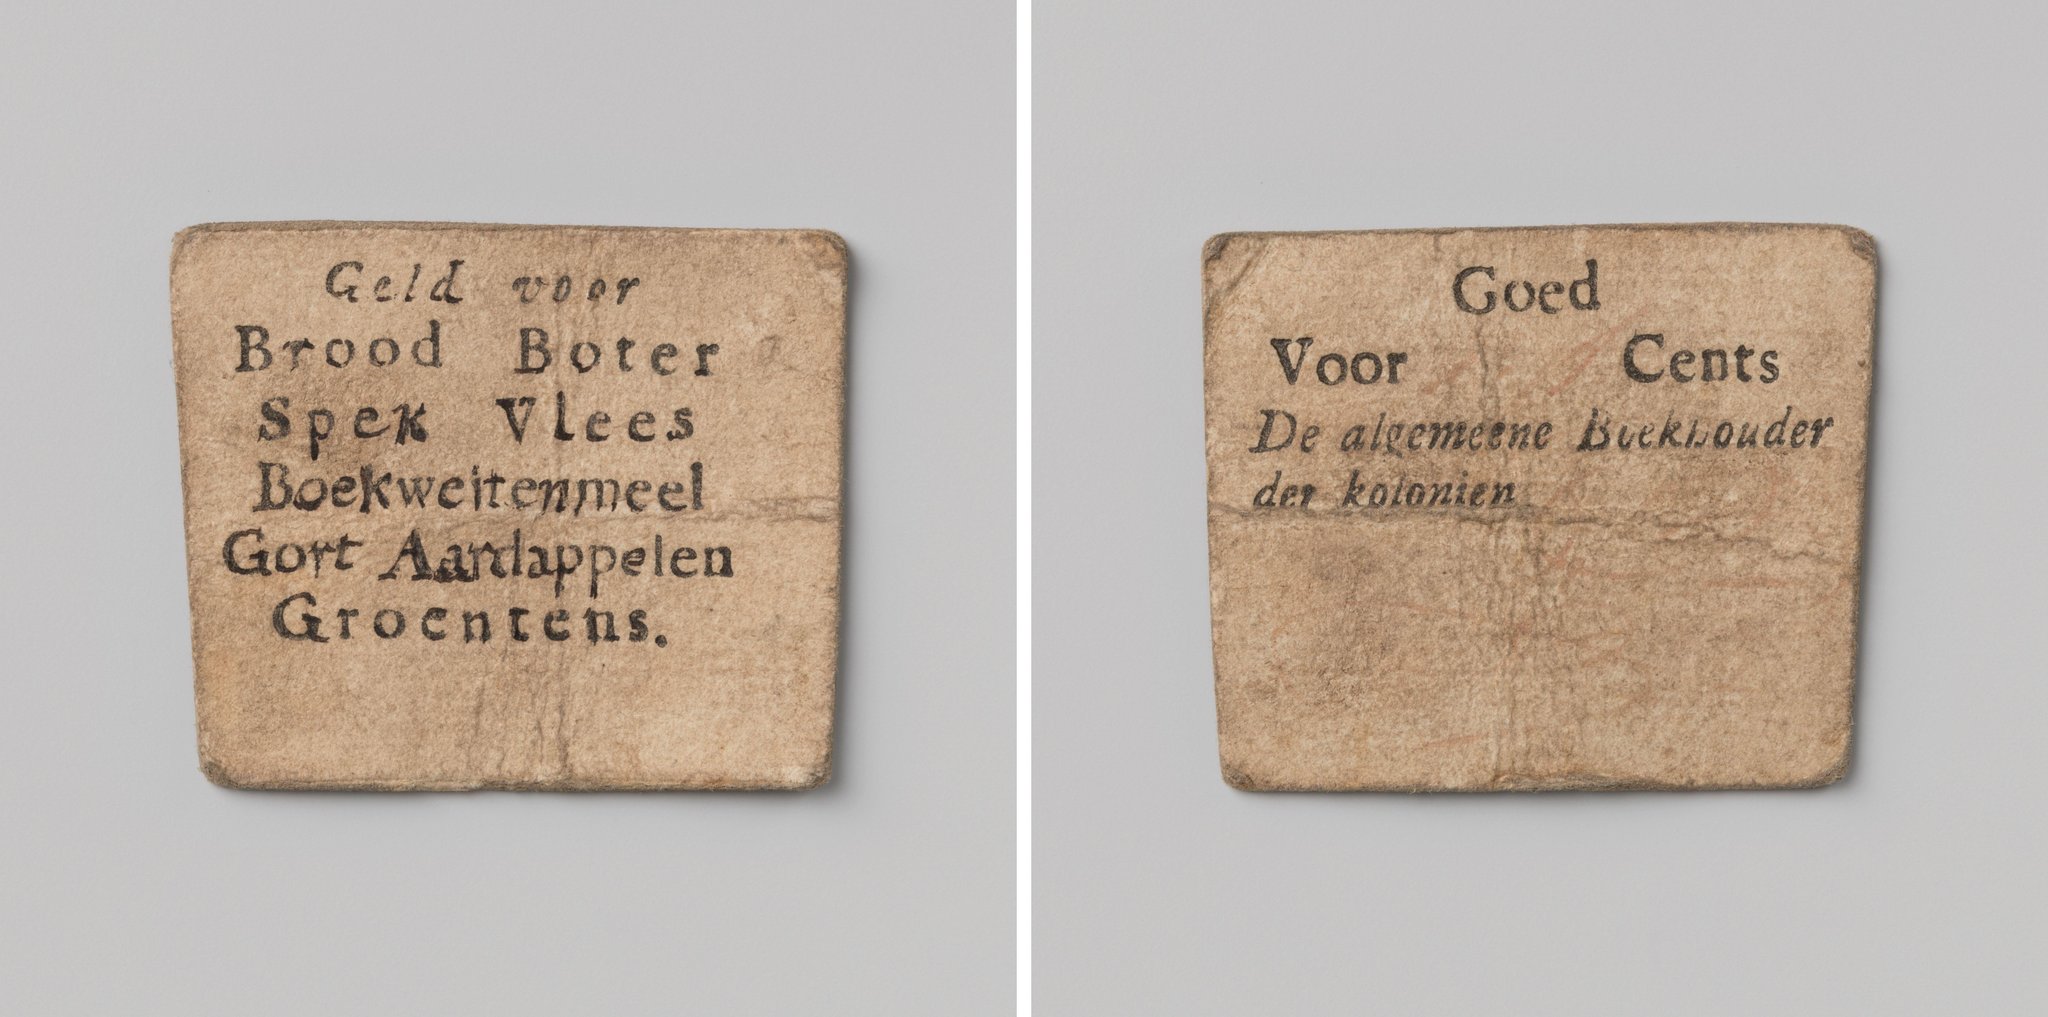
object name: huismunt prison money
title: Huismunt (winkelkaart) van onduidelijke waarde, uitgegeven door de algemene boekhouder der Koloniën van Weldadigheid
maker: william reese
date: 1826-1830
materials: cardboard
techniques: printing, writing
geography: frederiksoord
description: Rechthoekige munt van wit karton. Voorzijde: opschrift: "Geld voor Brood Boter Spek Vlees Boekweitmeel Gort Aardappelen Groentens.". Keerzijde: opschrift in vier regels: "Goed Voor Cents De algemeene Boekhouder der kolonien"; daartussen met zwarte inkt ingevuld: moeilijk leesbare waarde van munt.